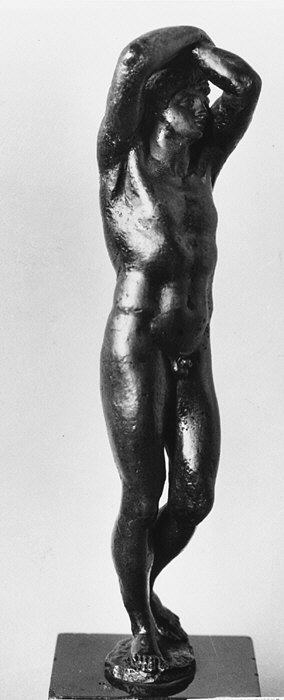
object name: statuette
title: Youth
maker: barthélemy prieur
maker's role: artist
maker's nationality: french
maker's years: 1536-1611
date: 1601-1700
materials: bronze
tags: male nudes